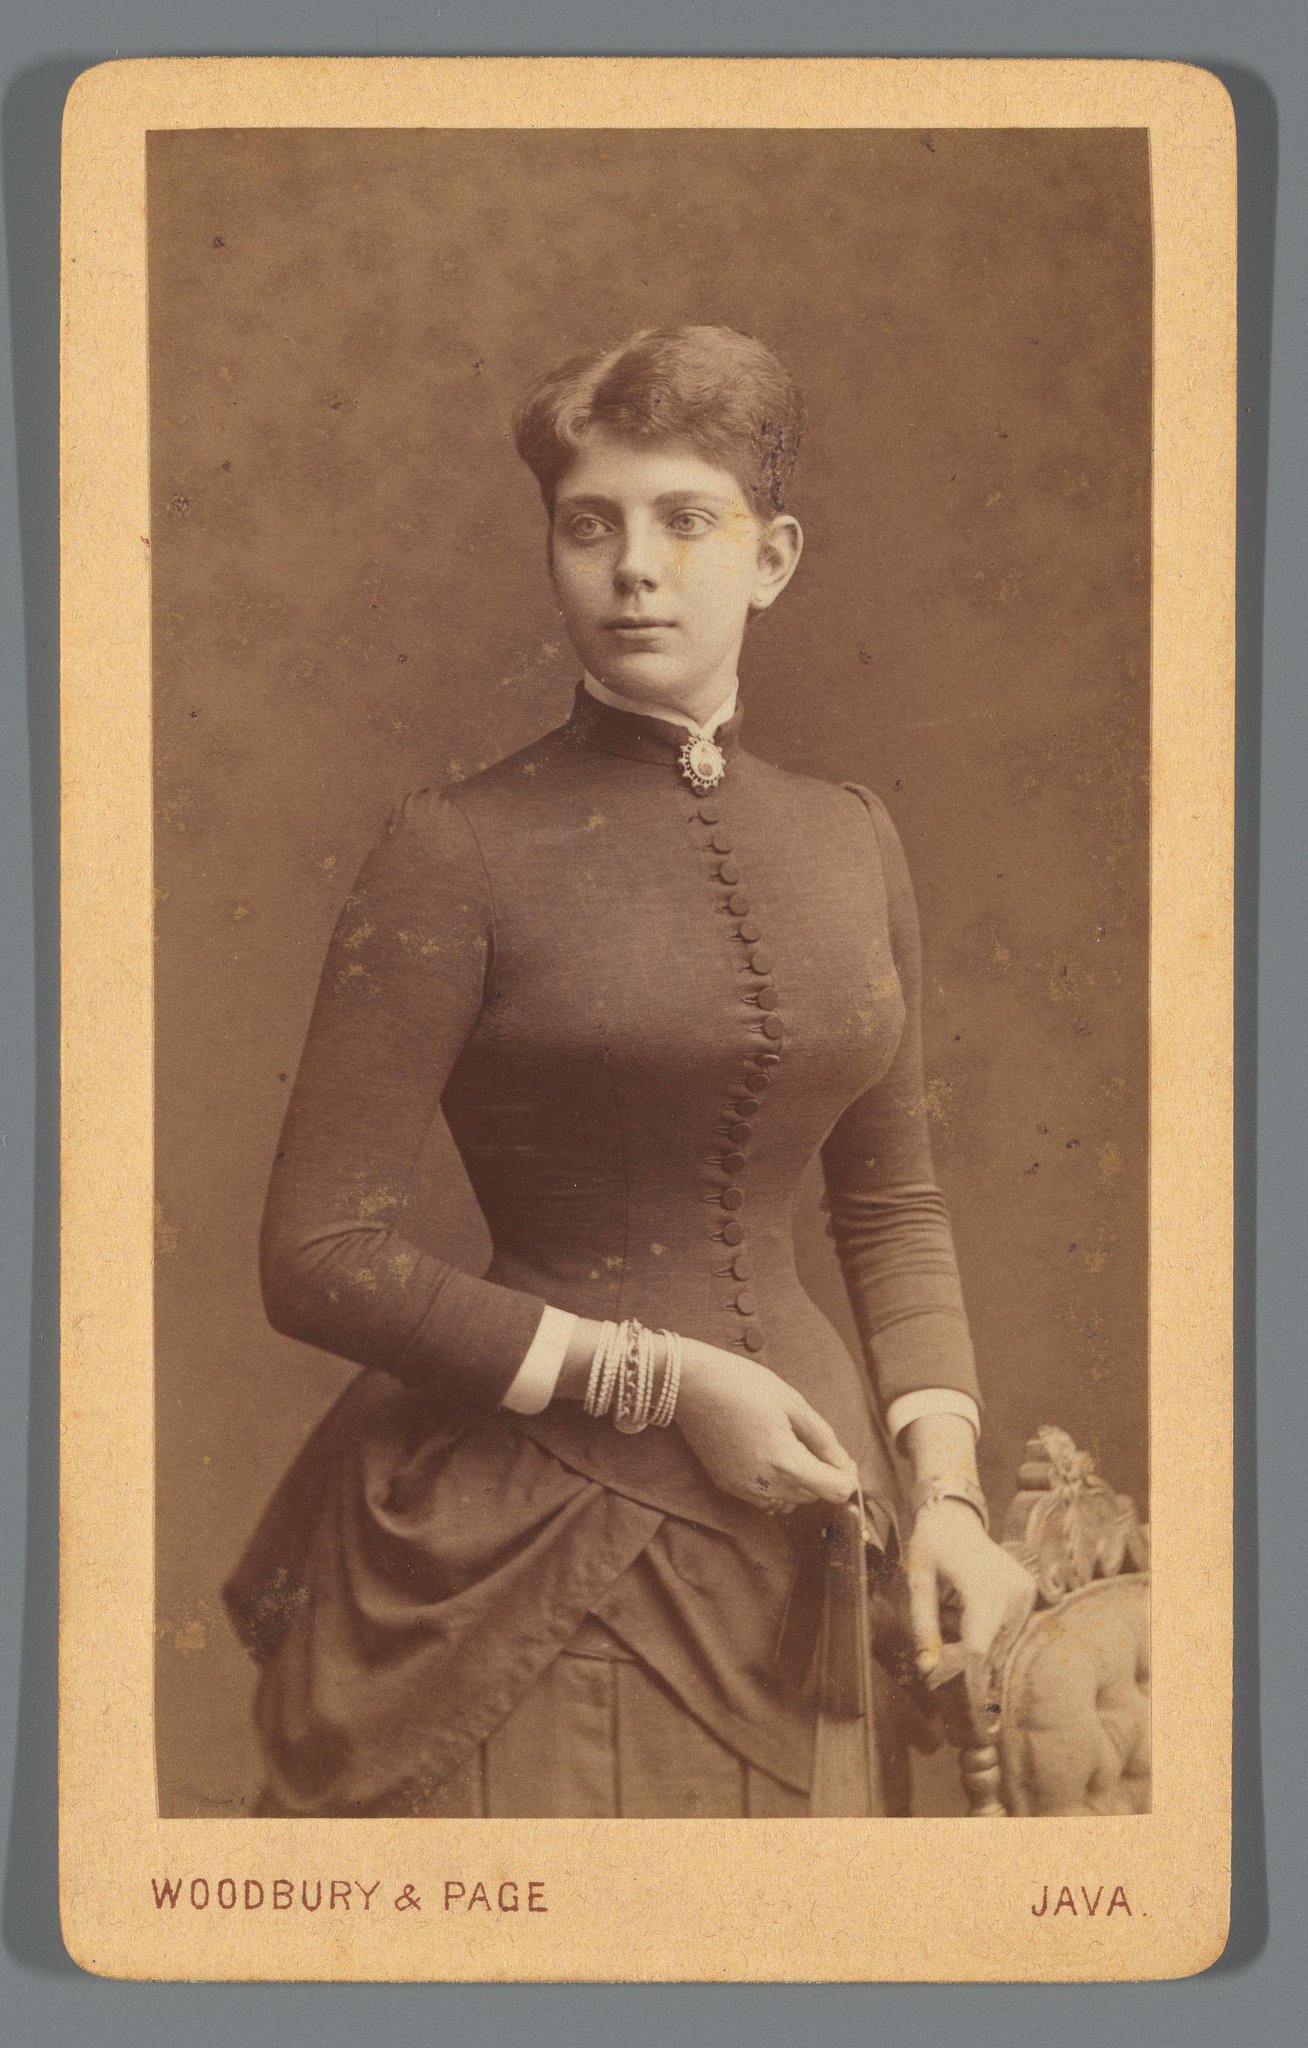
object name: photograph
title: Studioportret van Pauline van den Berg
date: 1870-1900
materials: cardboard, photographic support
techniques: albumen print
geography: java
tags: batavia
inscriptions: inscription: ‘t Pau v Blommestein / van den Berg’, name: ‘WOODBURY & PAGE / PHOTOGRAPHERS / JAVA.’, name: ‘WOODBURY & PAGE / JAVA’